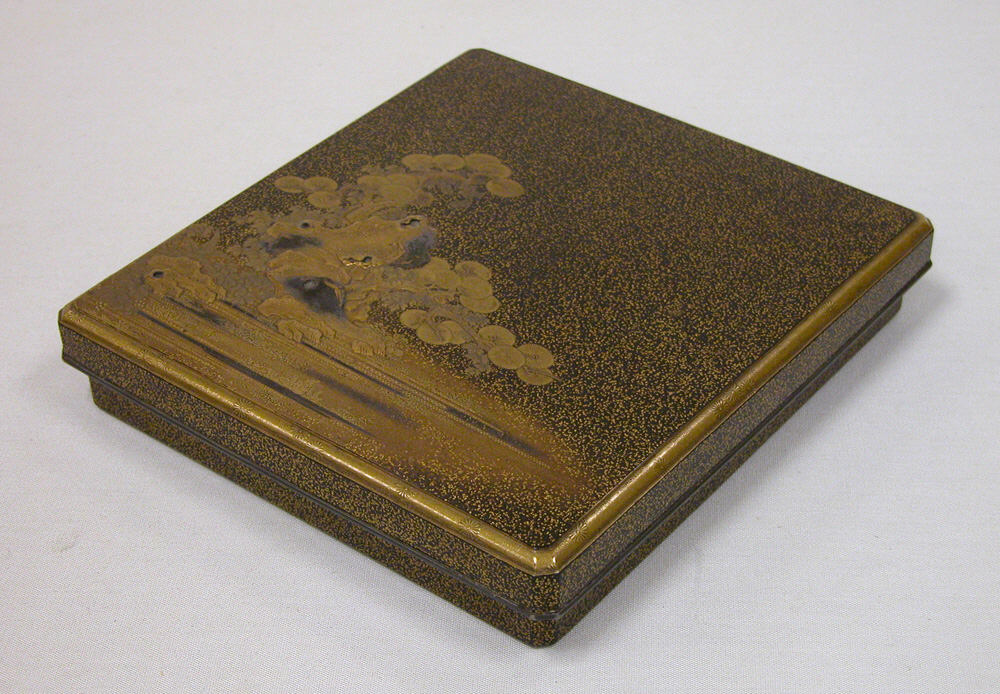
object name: writing box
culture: japanese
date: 1701-1800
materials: gold, lacquer, silver, wood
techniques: maki